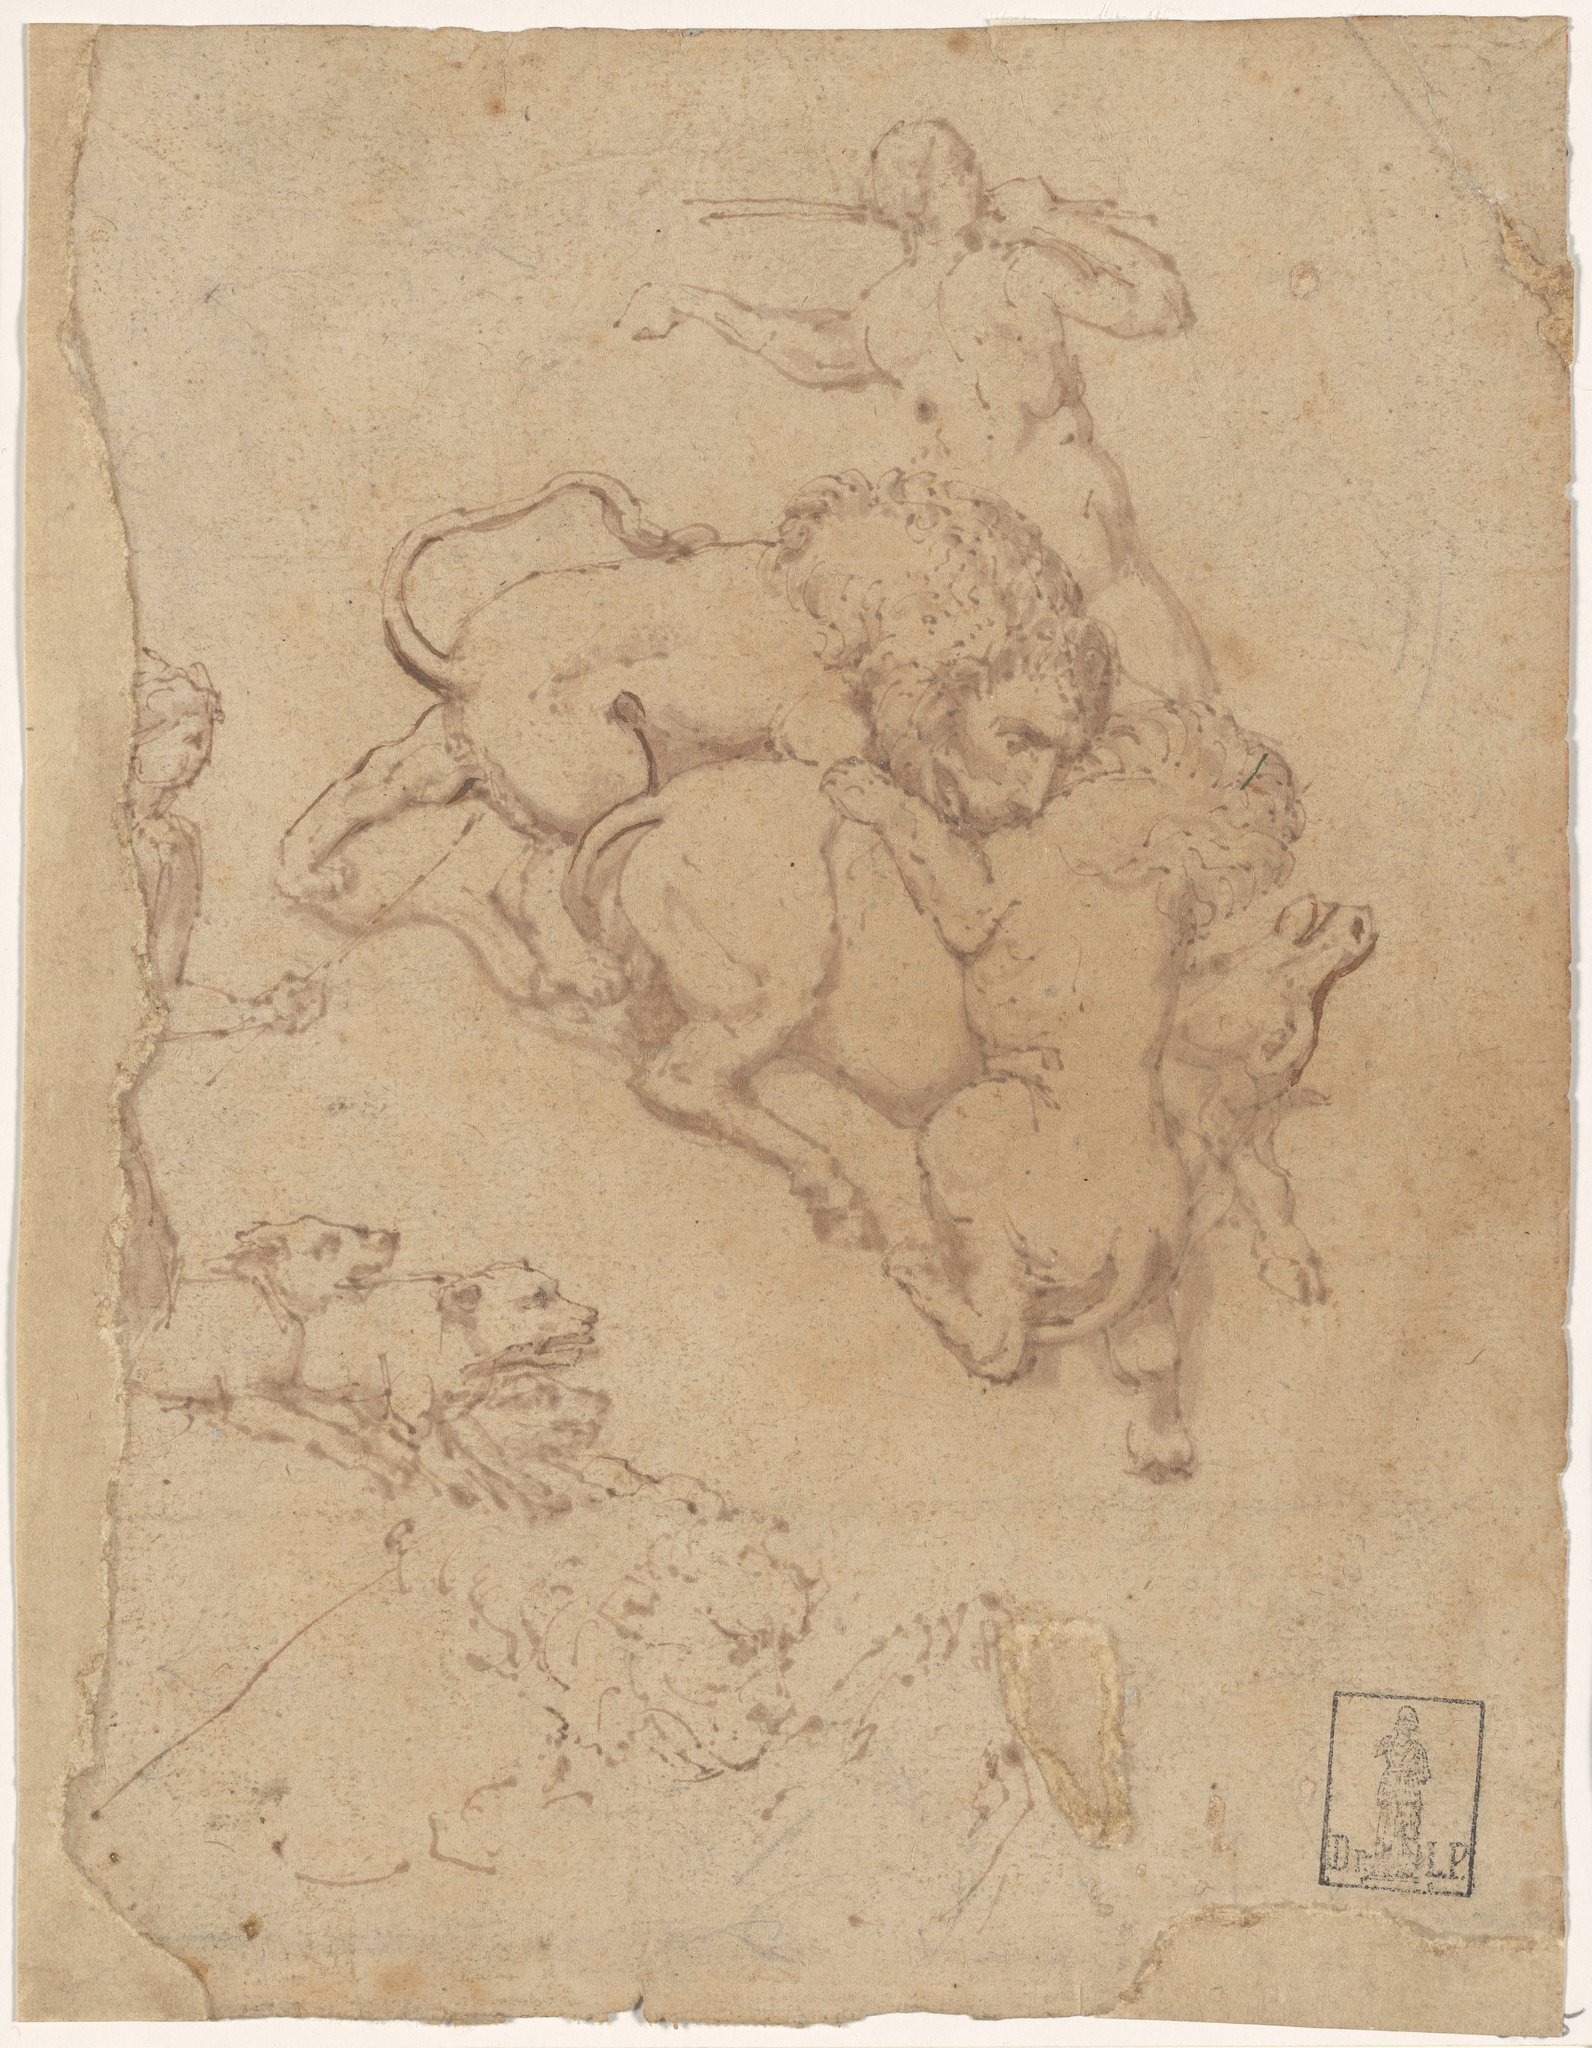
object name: drawing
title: Hunting Scene and Lions Attacking Animals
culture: italian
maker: the veneto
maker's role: artist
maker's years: 1570-1599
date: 1567-1600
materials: ink, paper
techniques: brush, pen, wash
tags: men,hunting,dogs,lions